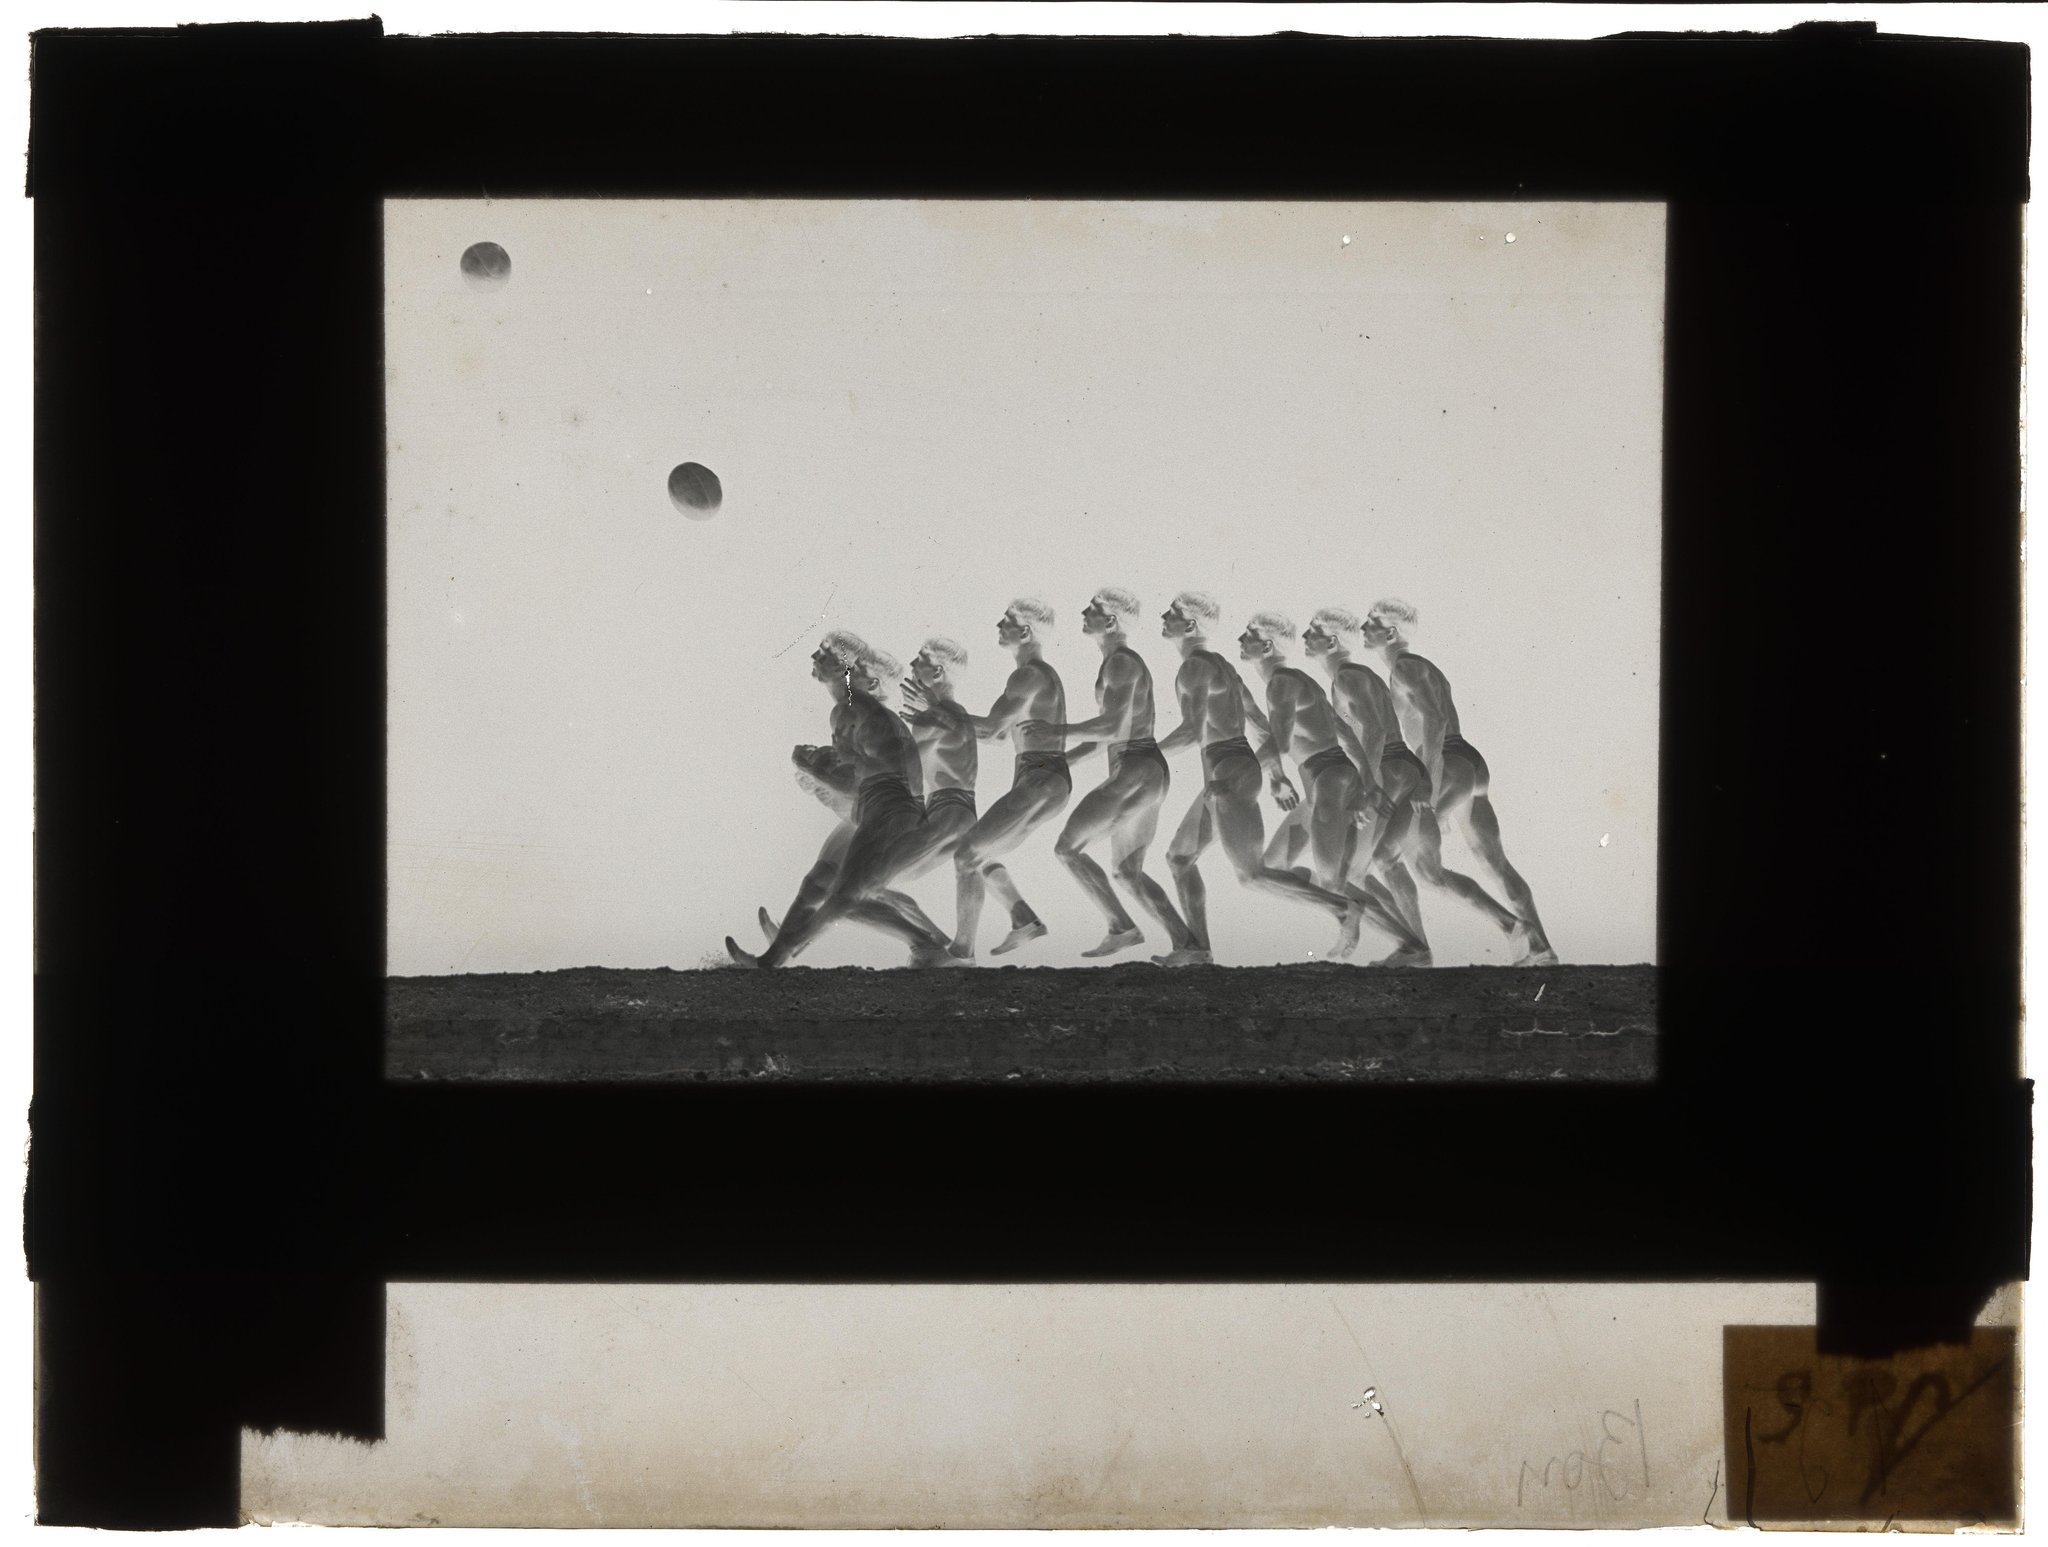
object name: glasnegatief, glasplaatnegatief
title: Man neemt aanloop en schiet de bal in de lucht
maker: étienne-jules marey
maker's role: fotograaf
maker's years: 1830-1904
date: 1882-1890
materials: glass, paper, pencil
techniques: gelatin glass negative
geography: france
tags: adult man, ball games, automobile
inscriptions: inscription: ‘Id 5’, inscription: ‘Bon’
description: Bij de negatieven zijn ook de duplicaatnegatieven en moderne afdrukken die voor de boekpublicatie vervaardigd zijn.